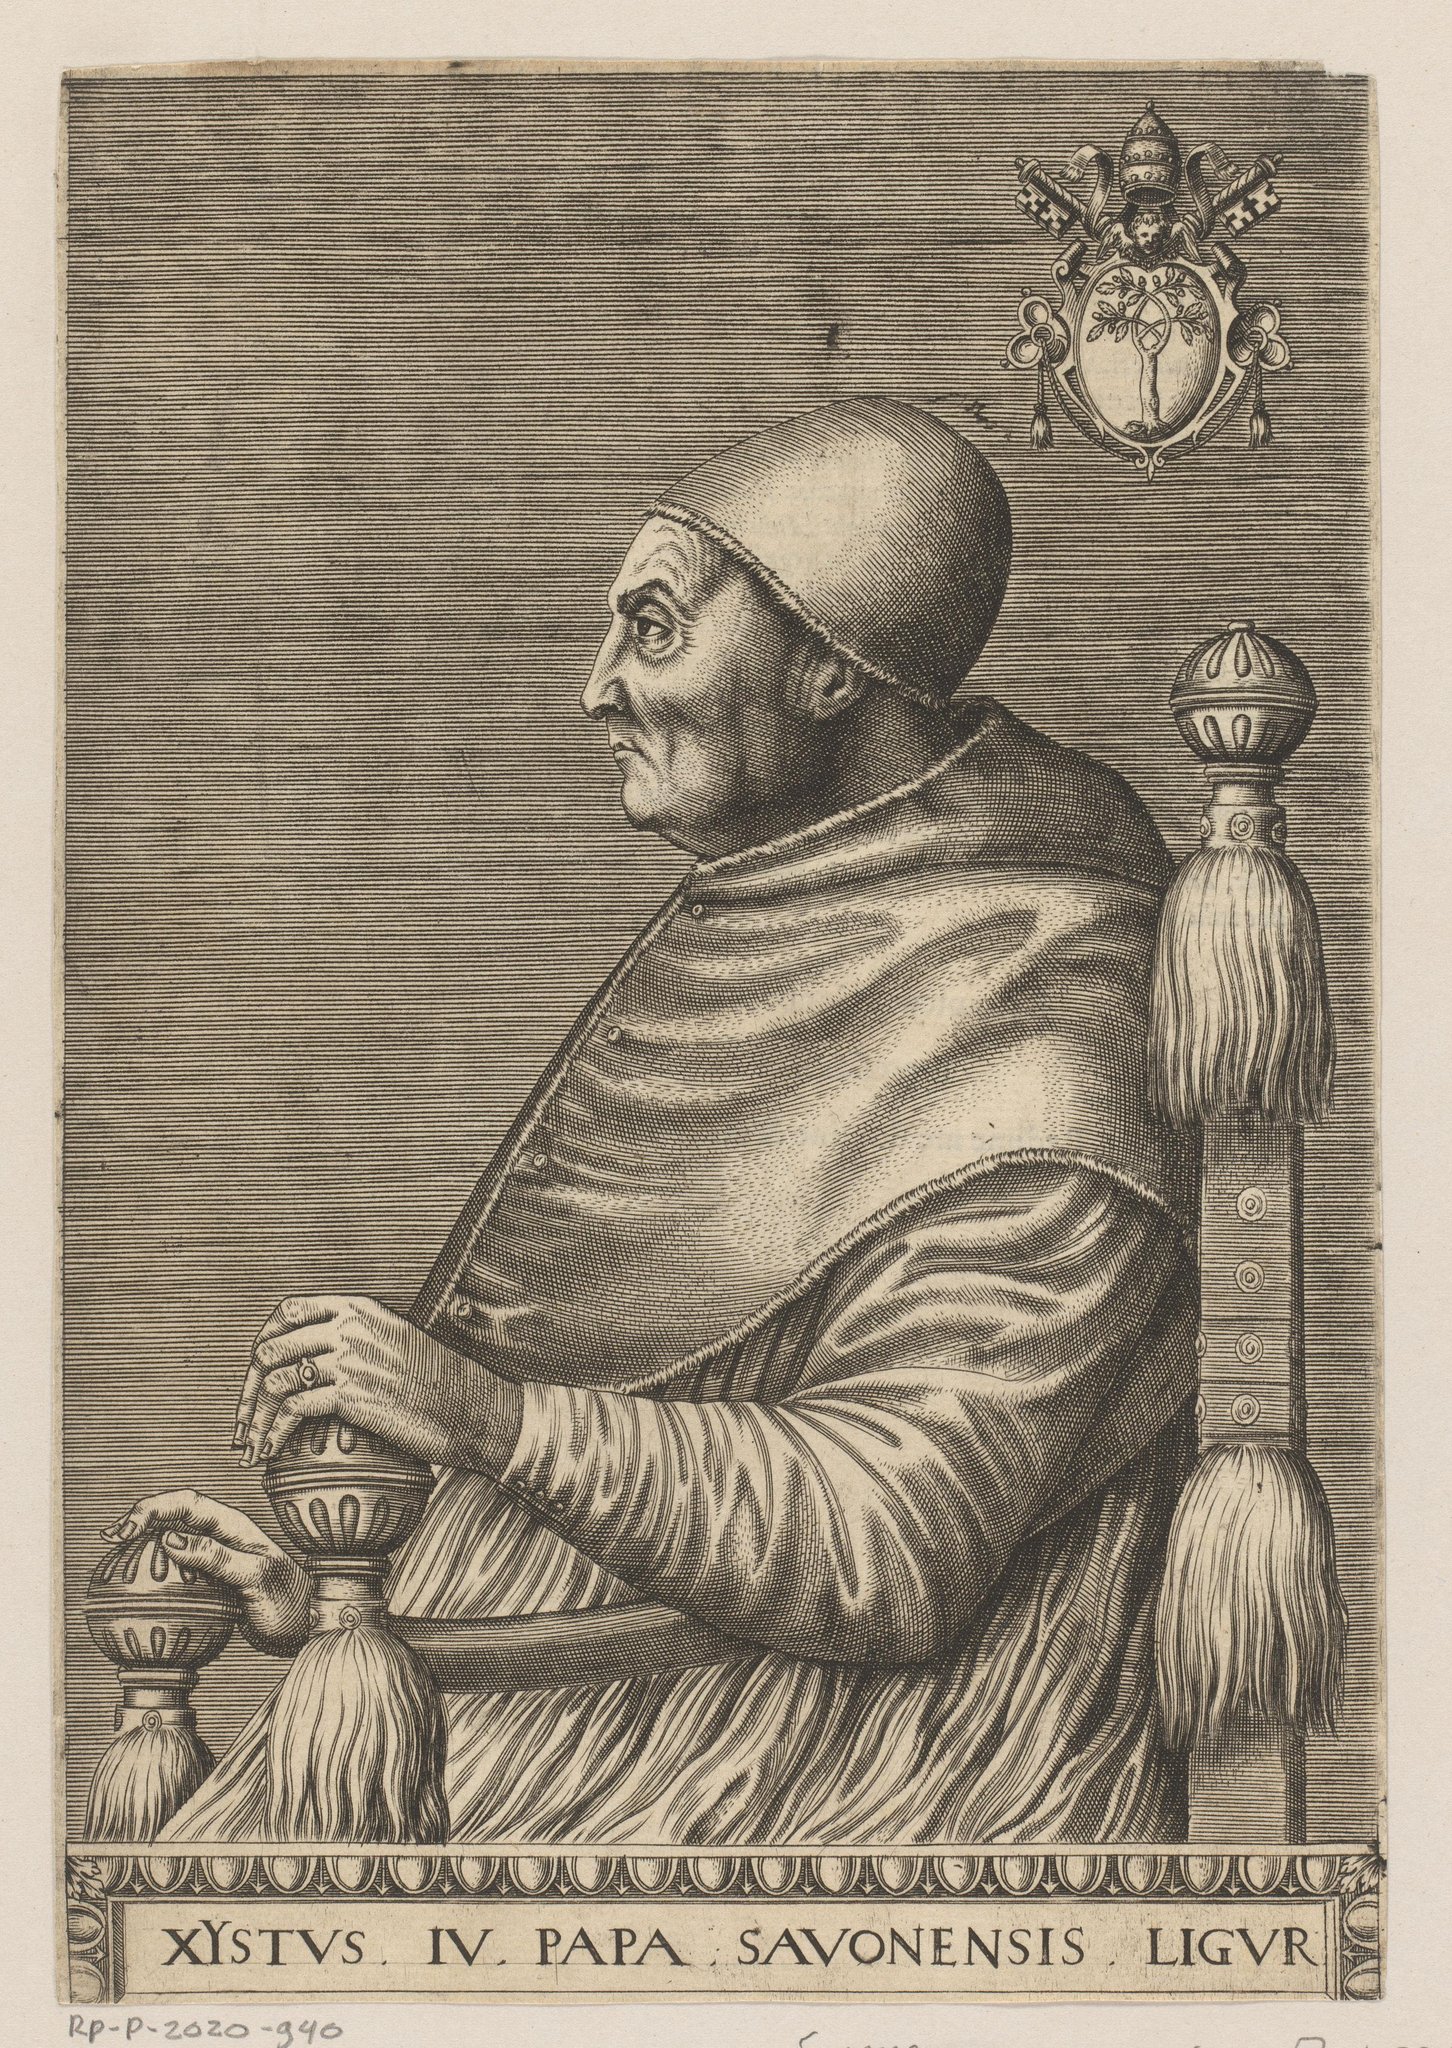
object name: print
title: Xystus IV papa Savonensis Ligur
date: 1568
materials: paper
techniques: engraving, letterpress printing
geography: rome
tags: rome, historical persons, pope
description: Prent uit: Panvinio, Onofrio. 27 pontificum maximorum elogia et imagines accuratissime ad uiuum aeneis typeis delineatae. Rome: Antonio Lafreri, 1568.